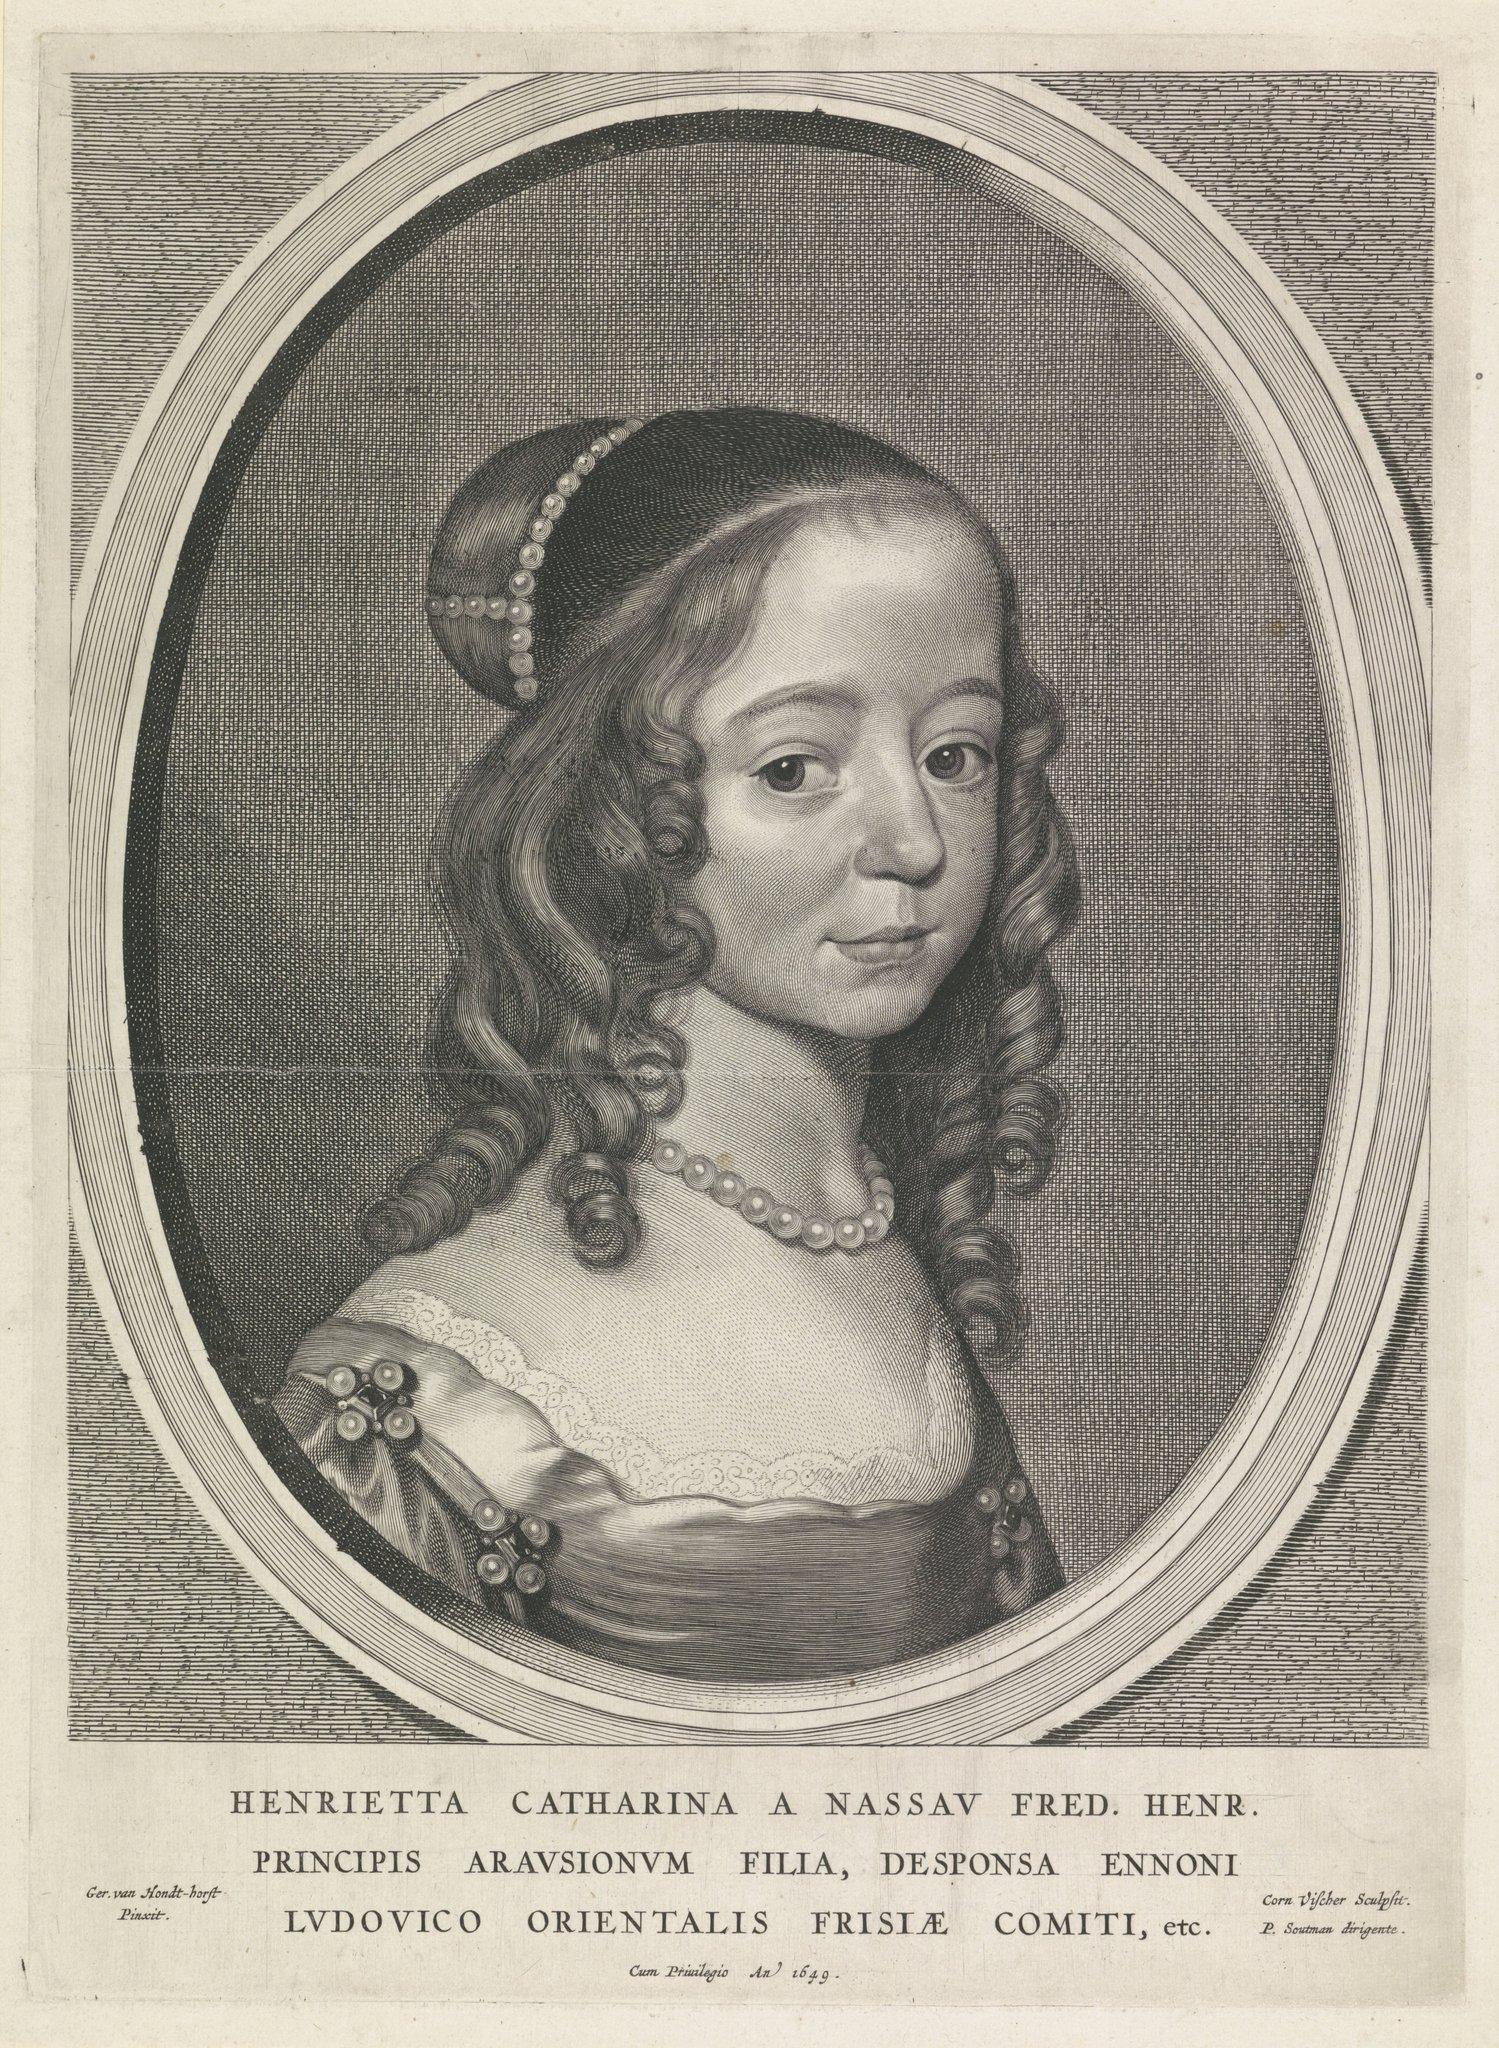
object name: print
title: Fredericus Henricus Illustrissimus Orangiae Princeps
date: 1649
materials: paper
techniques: engraving, etching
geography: haarlem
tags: the hague, henriëtte catharina (prinses van oranje)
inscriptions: collector's mark: Lugt 240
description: De hier vermelde titel verwijst naar de hoogst verkregen titel van de geportretteerde, niet per se naar de titel die de geportretteerde op deze voorstelling draagt.